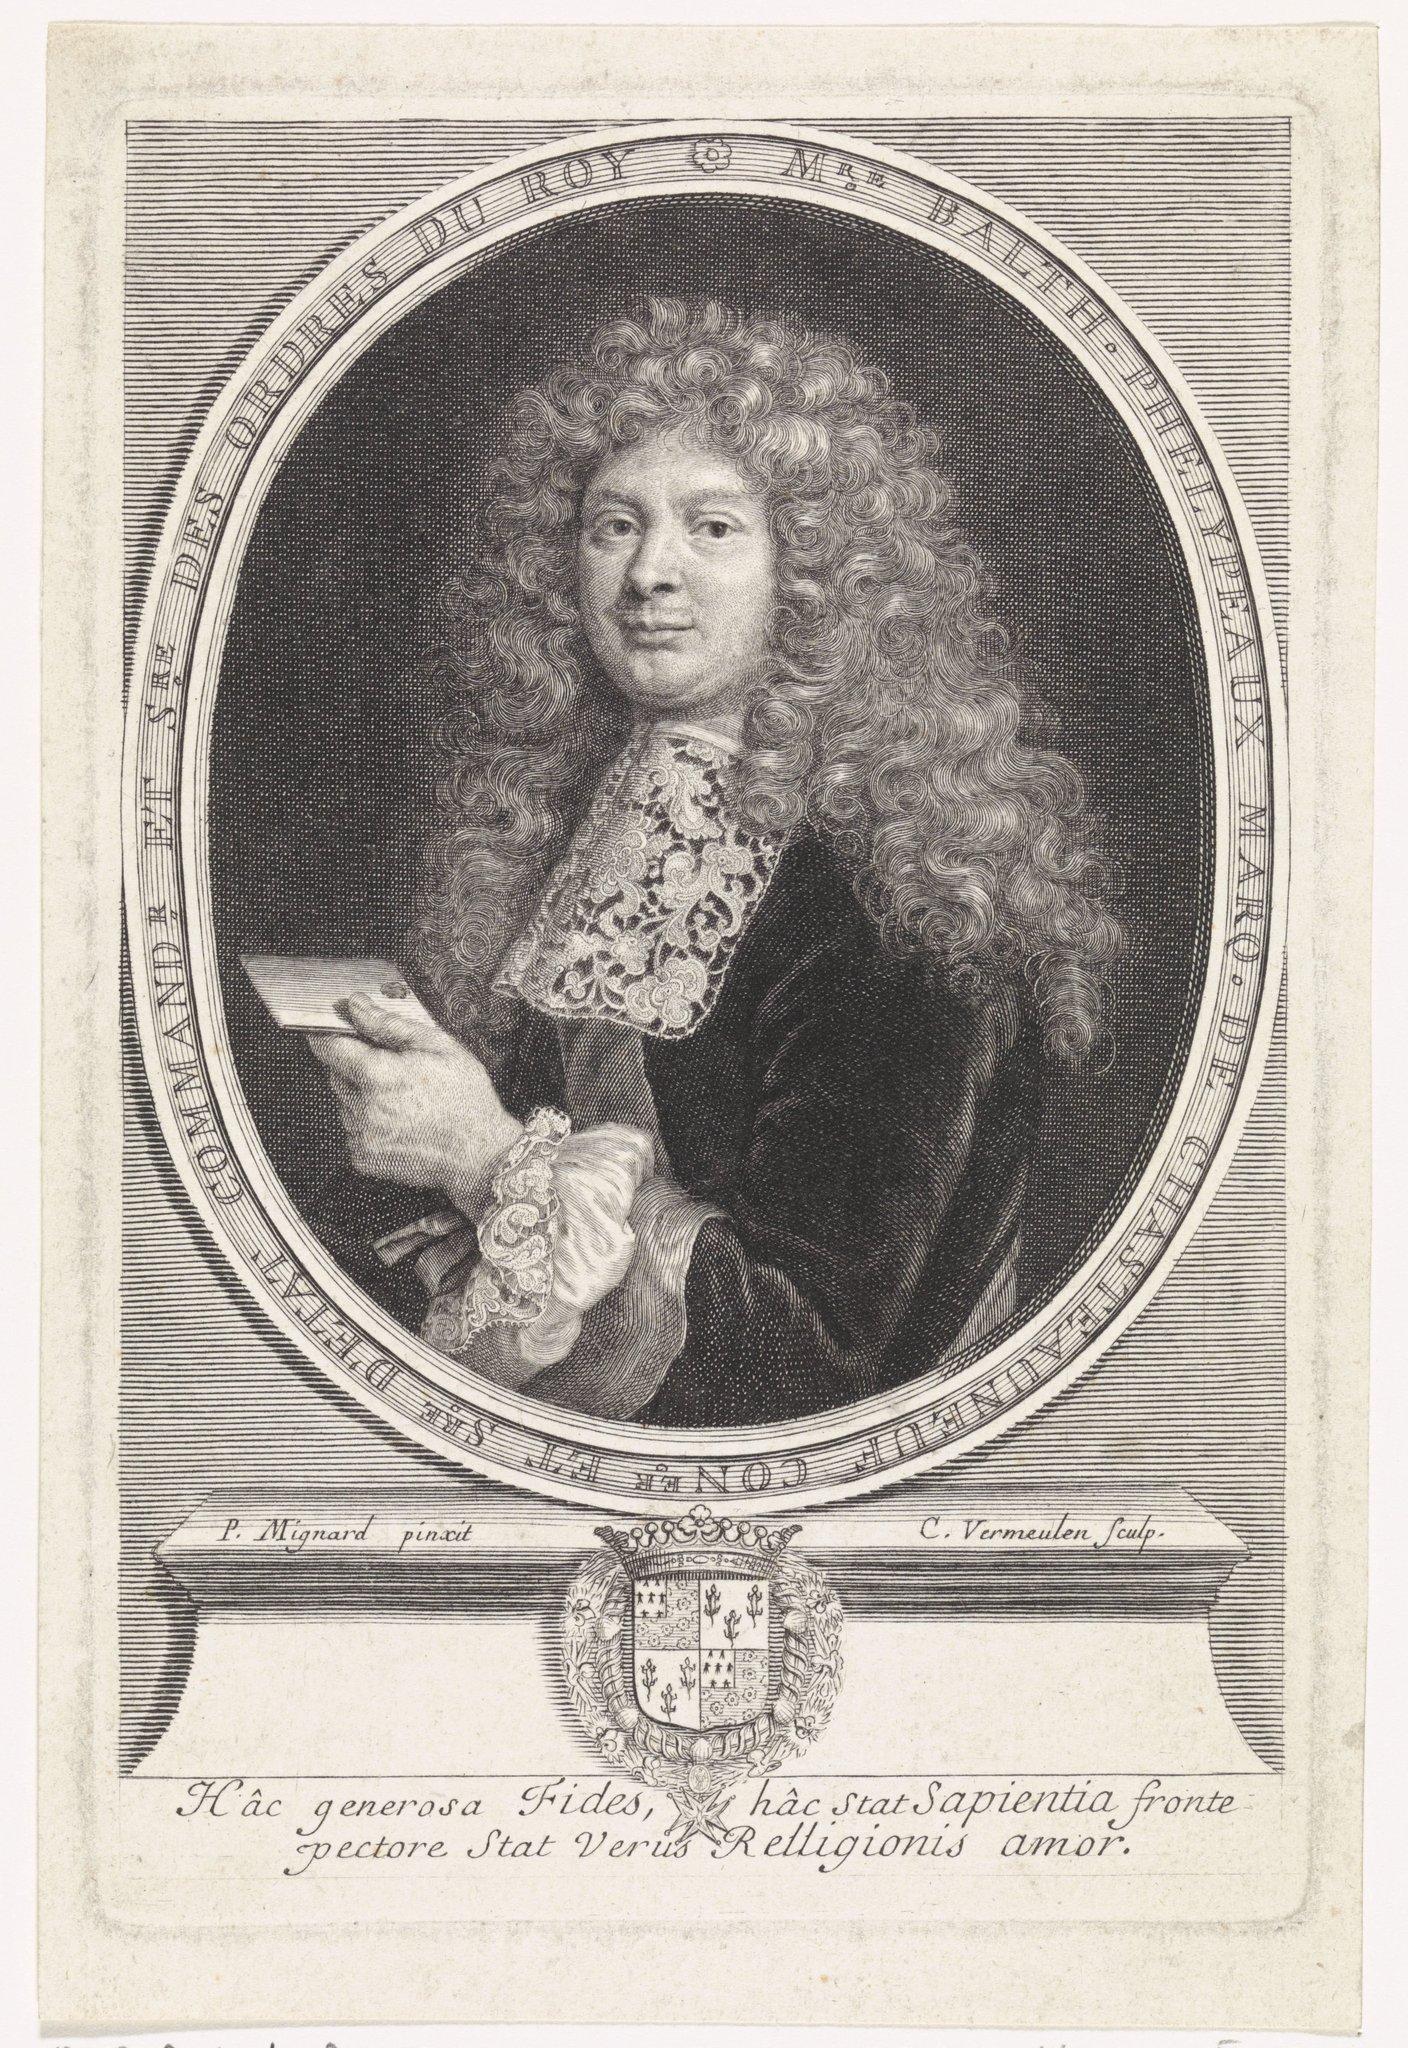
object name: print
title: Portret van Balthazar Phélypeaux de Châteauneuf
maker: pierre mignard (1612-1695)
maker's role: draughtsman, painter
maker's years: 1612-1695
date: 1669-1709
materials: paper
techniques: engraving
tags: historical persons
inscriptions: collector's mark: Lugt 2228